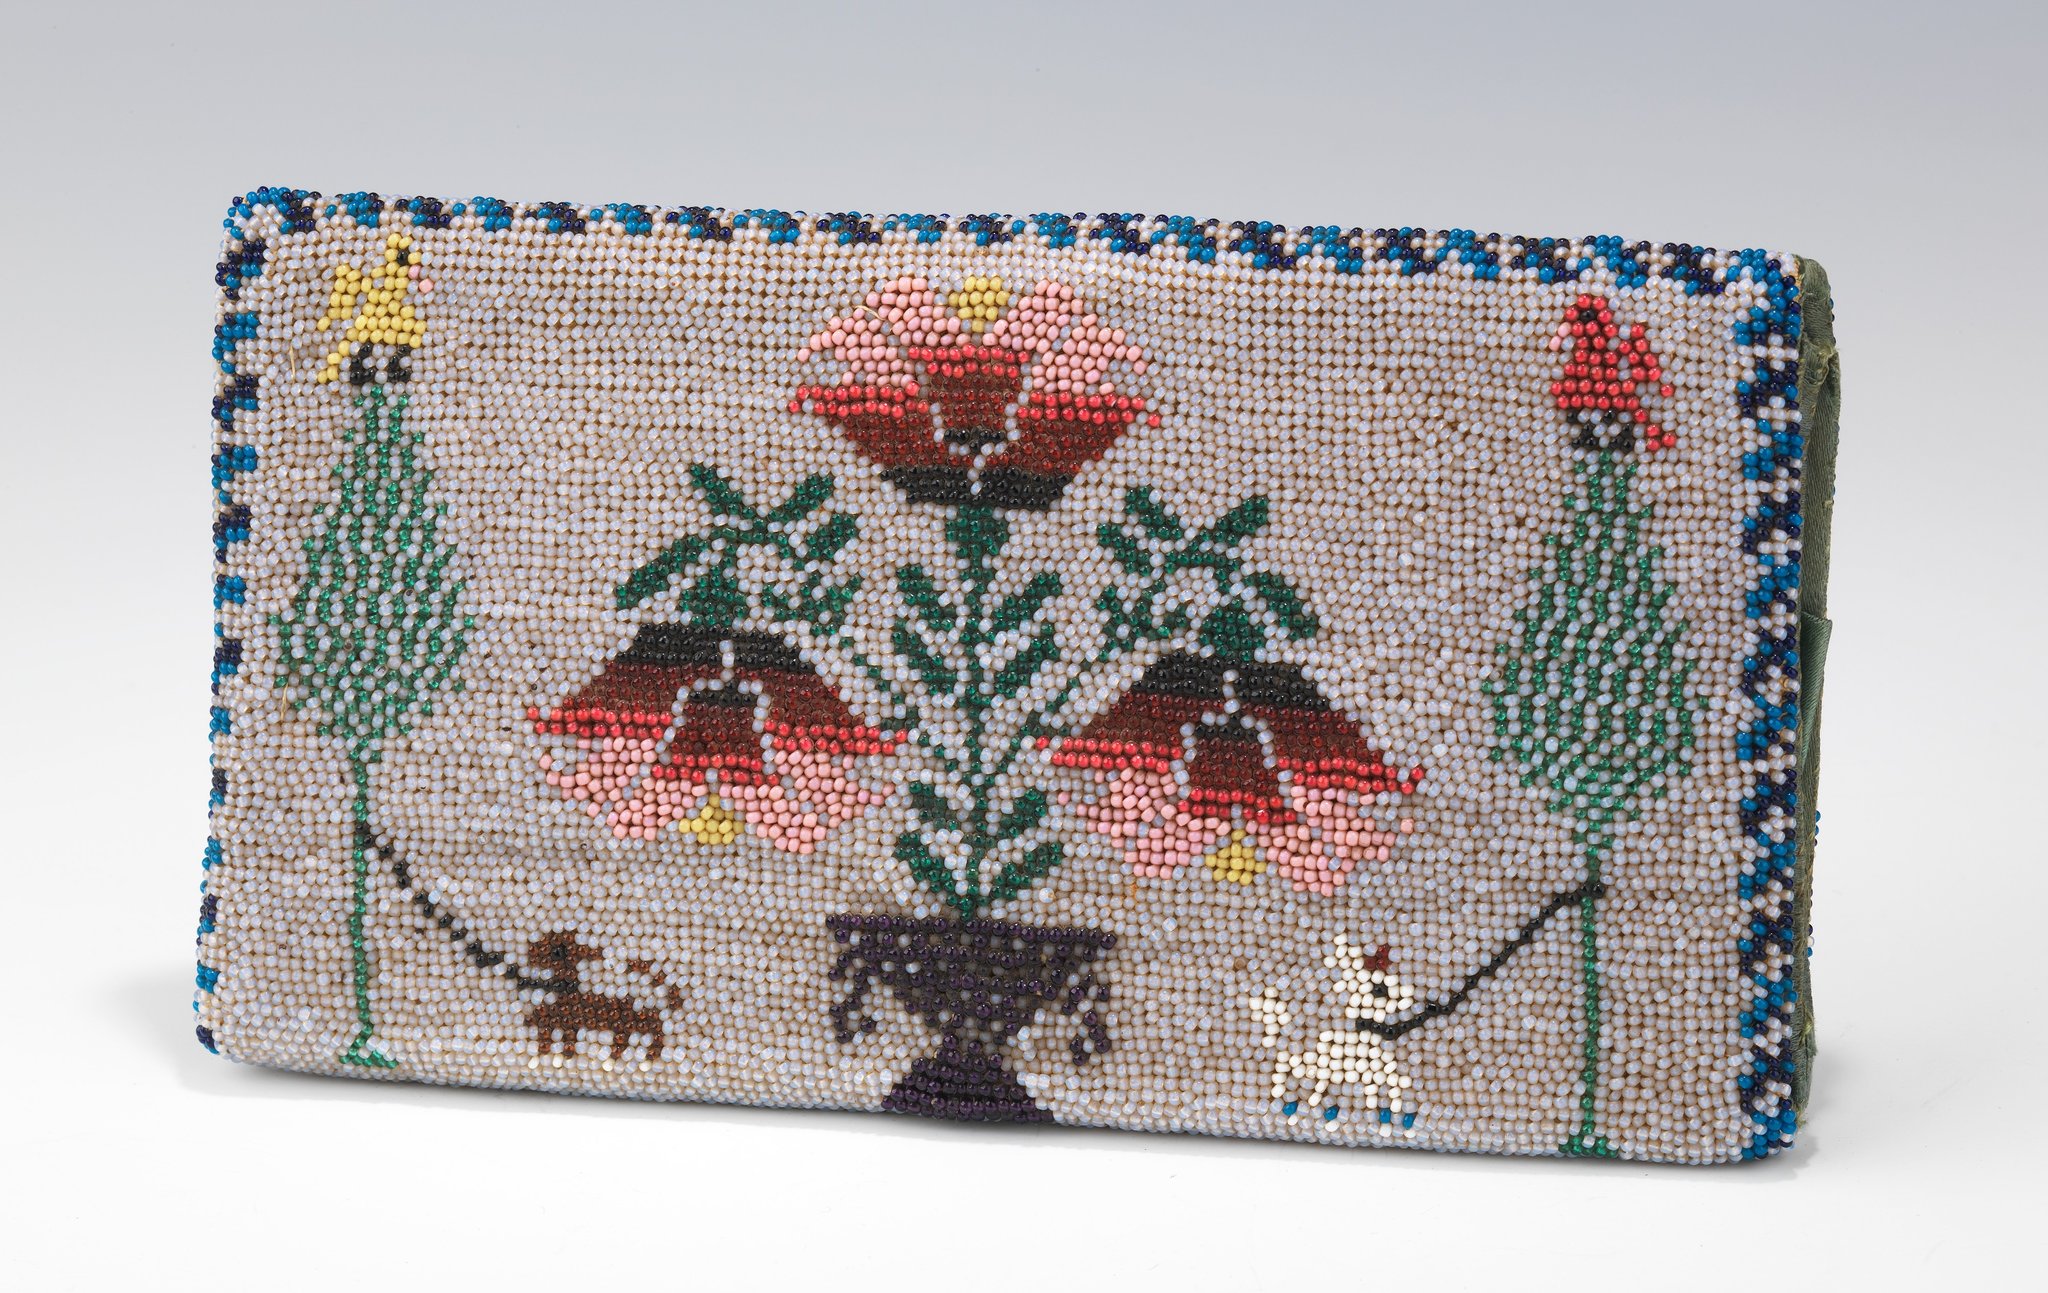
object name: purse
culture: mexican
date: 1800-1830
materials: glass, paper, silk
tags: birds,dogs,trees